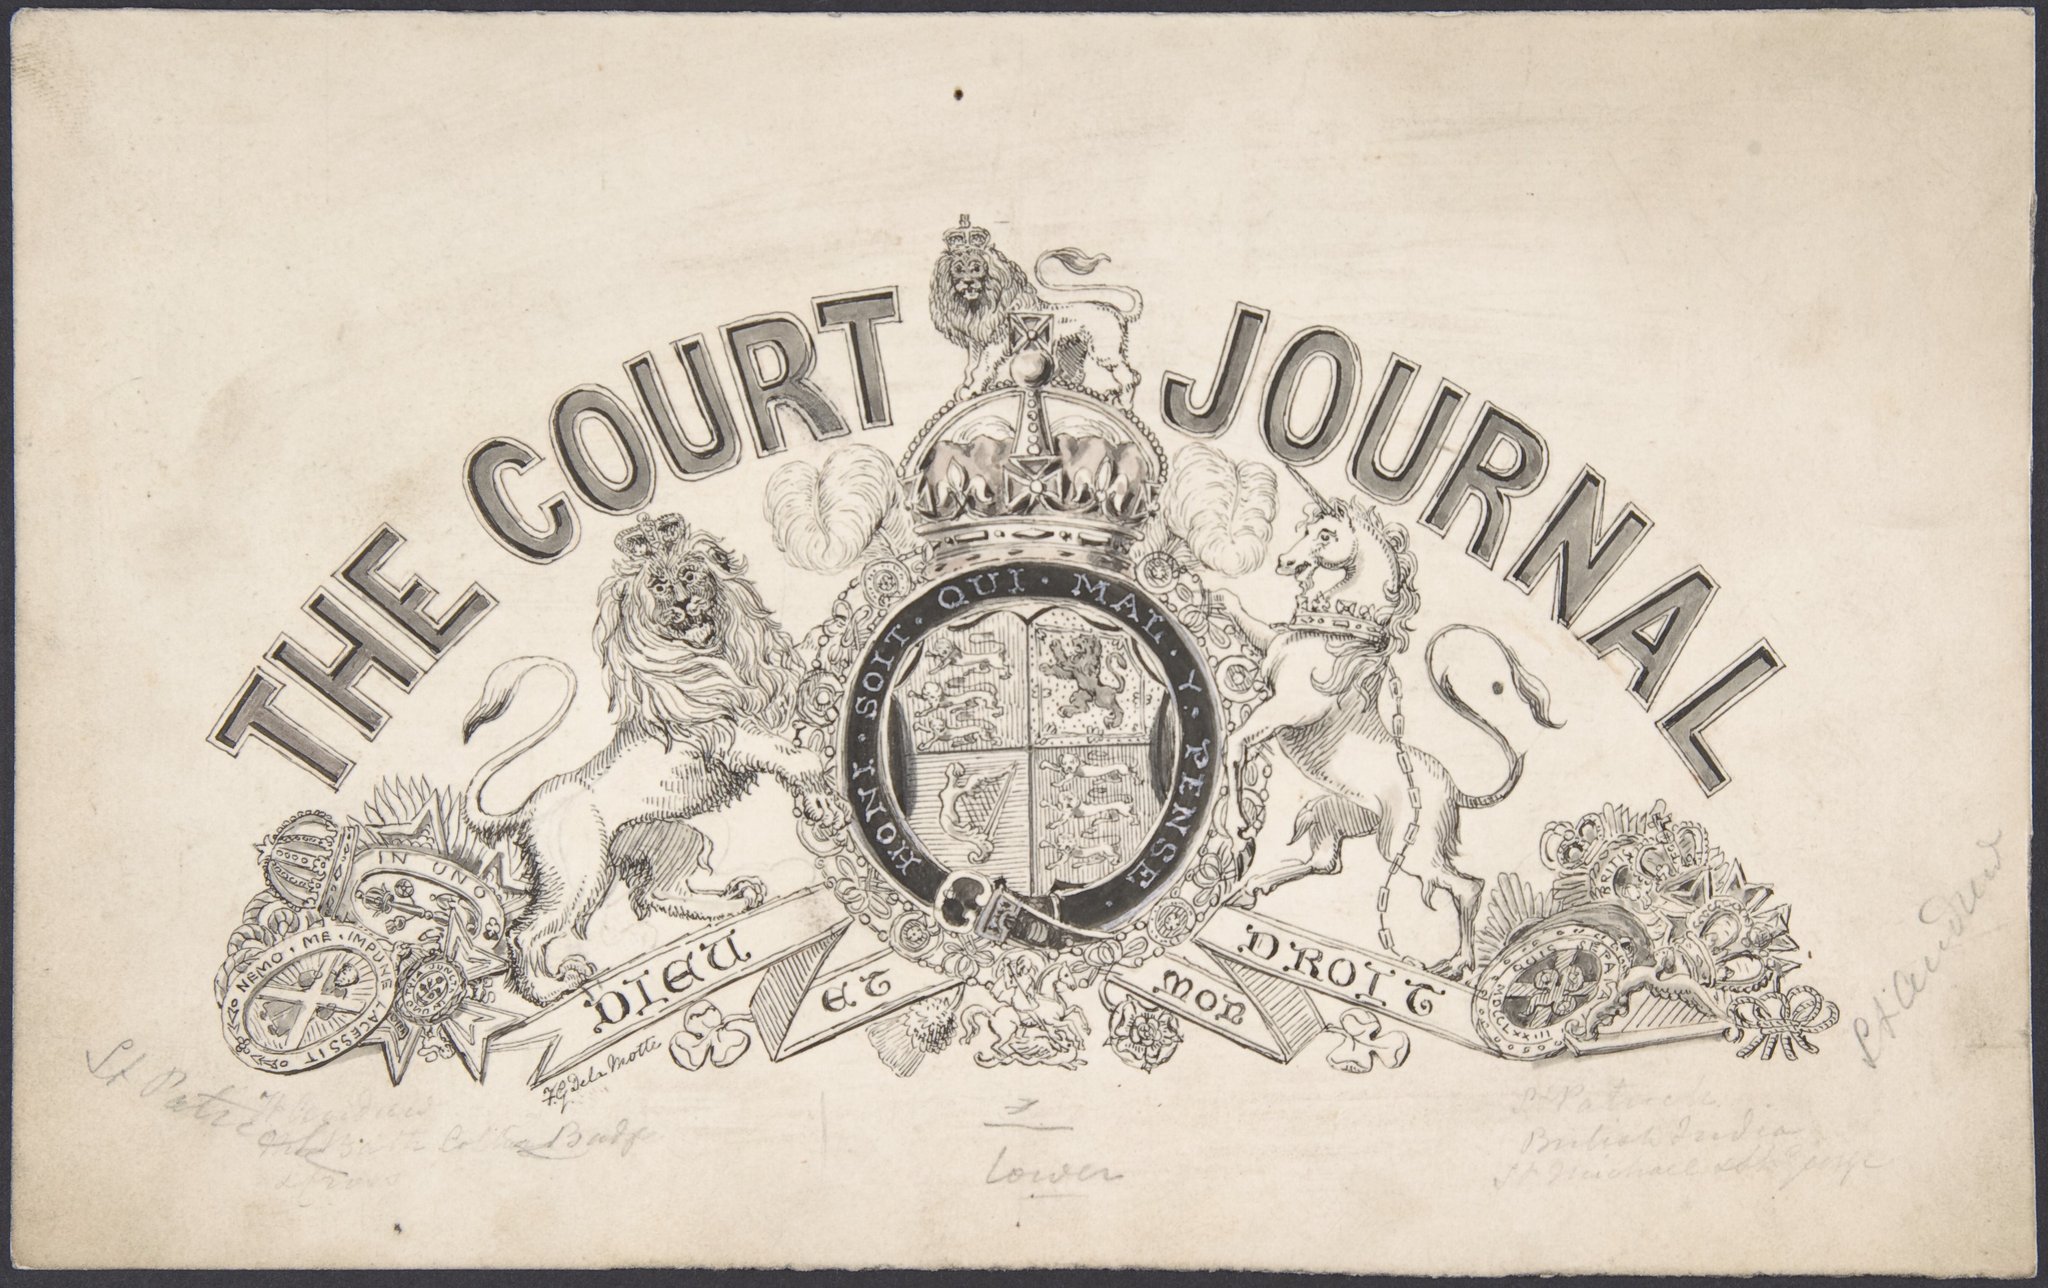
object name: drawing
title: Title page design for "The Court Journal"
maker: freeman gage delamotte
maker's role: artist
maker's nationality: british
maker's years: 1813-1862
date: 1830-1862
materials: gouache, graphite, ink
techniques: brush, pen, wash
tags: coat of arms